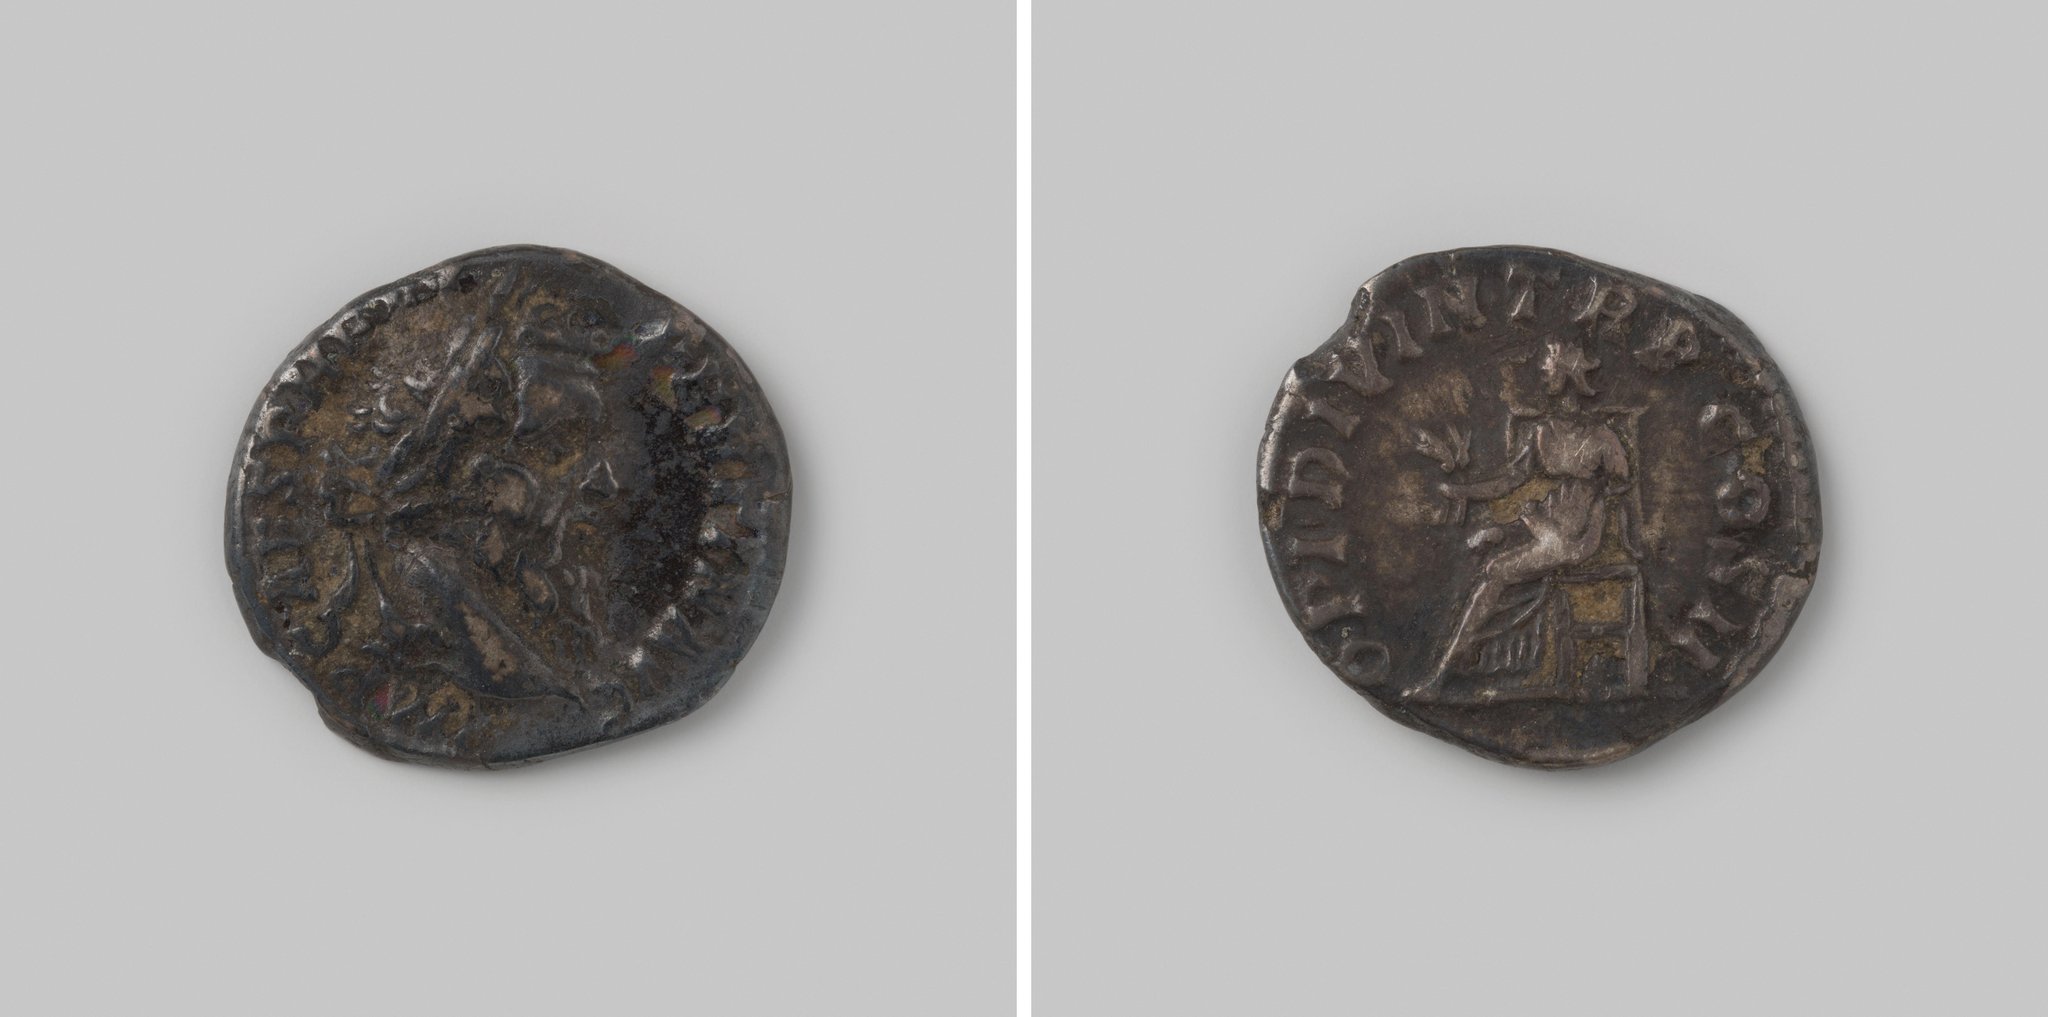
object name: denarius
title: Denarius uit het Romeinse Keizerrijk van Pertinax, 193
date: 193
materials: silver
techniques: striking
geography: rome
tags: ops (opis), pertinax (keizer van het romeinse rijk)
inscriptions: circumscription: ‘OPI DIVIN TR P COS II’, circumscription: ‘IMP CAES P HELV PERTIN AVG’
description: keerzijde: Ops, de godin van de rijkdom, zittend naar links met twee korenaren in rechterhand